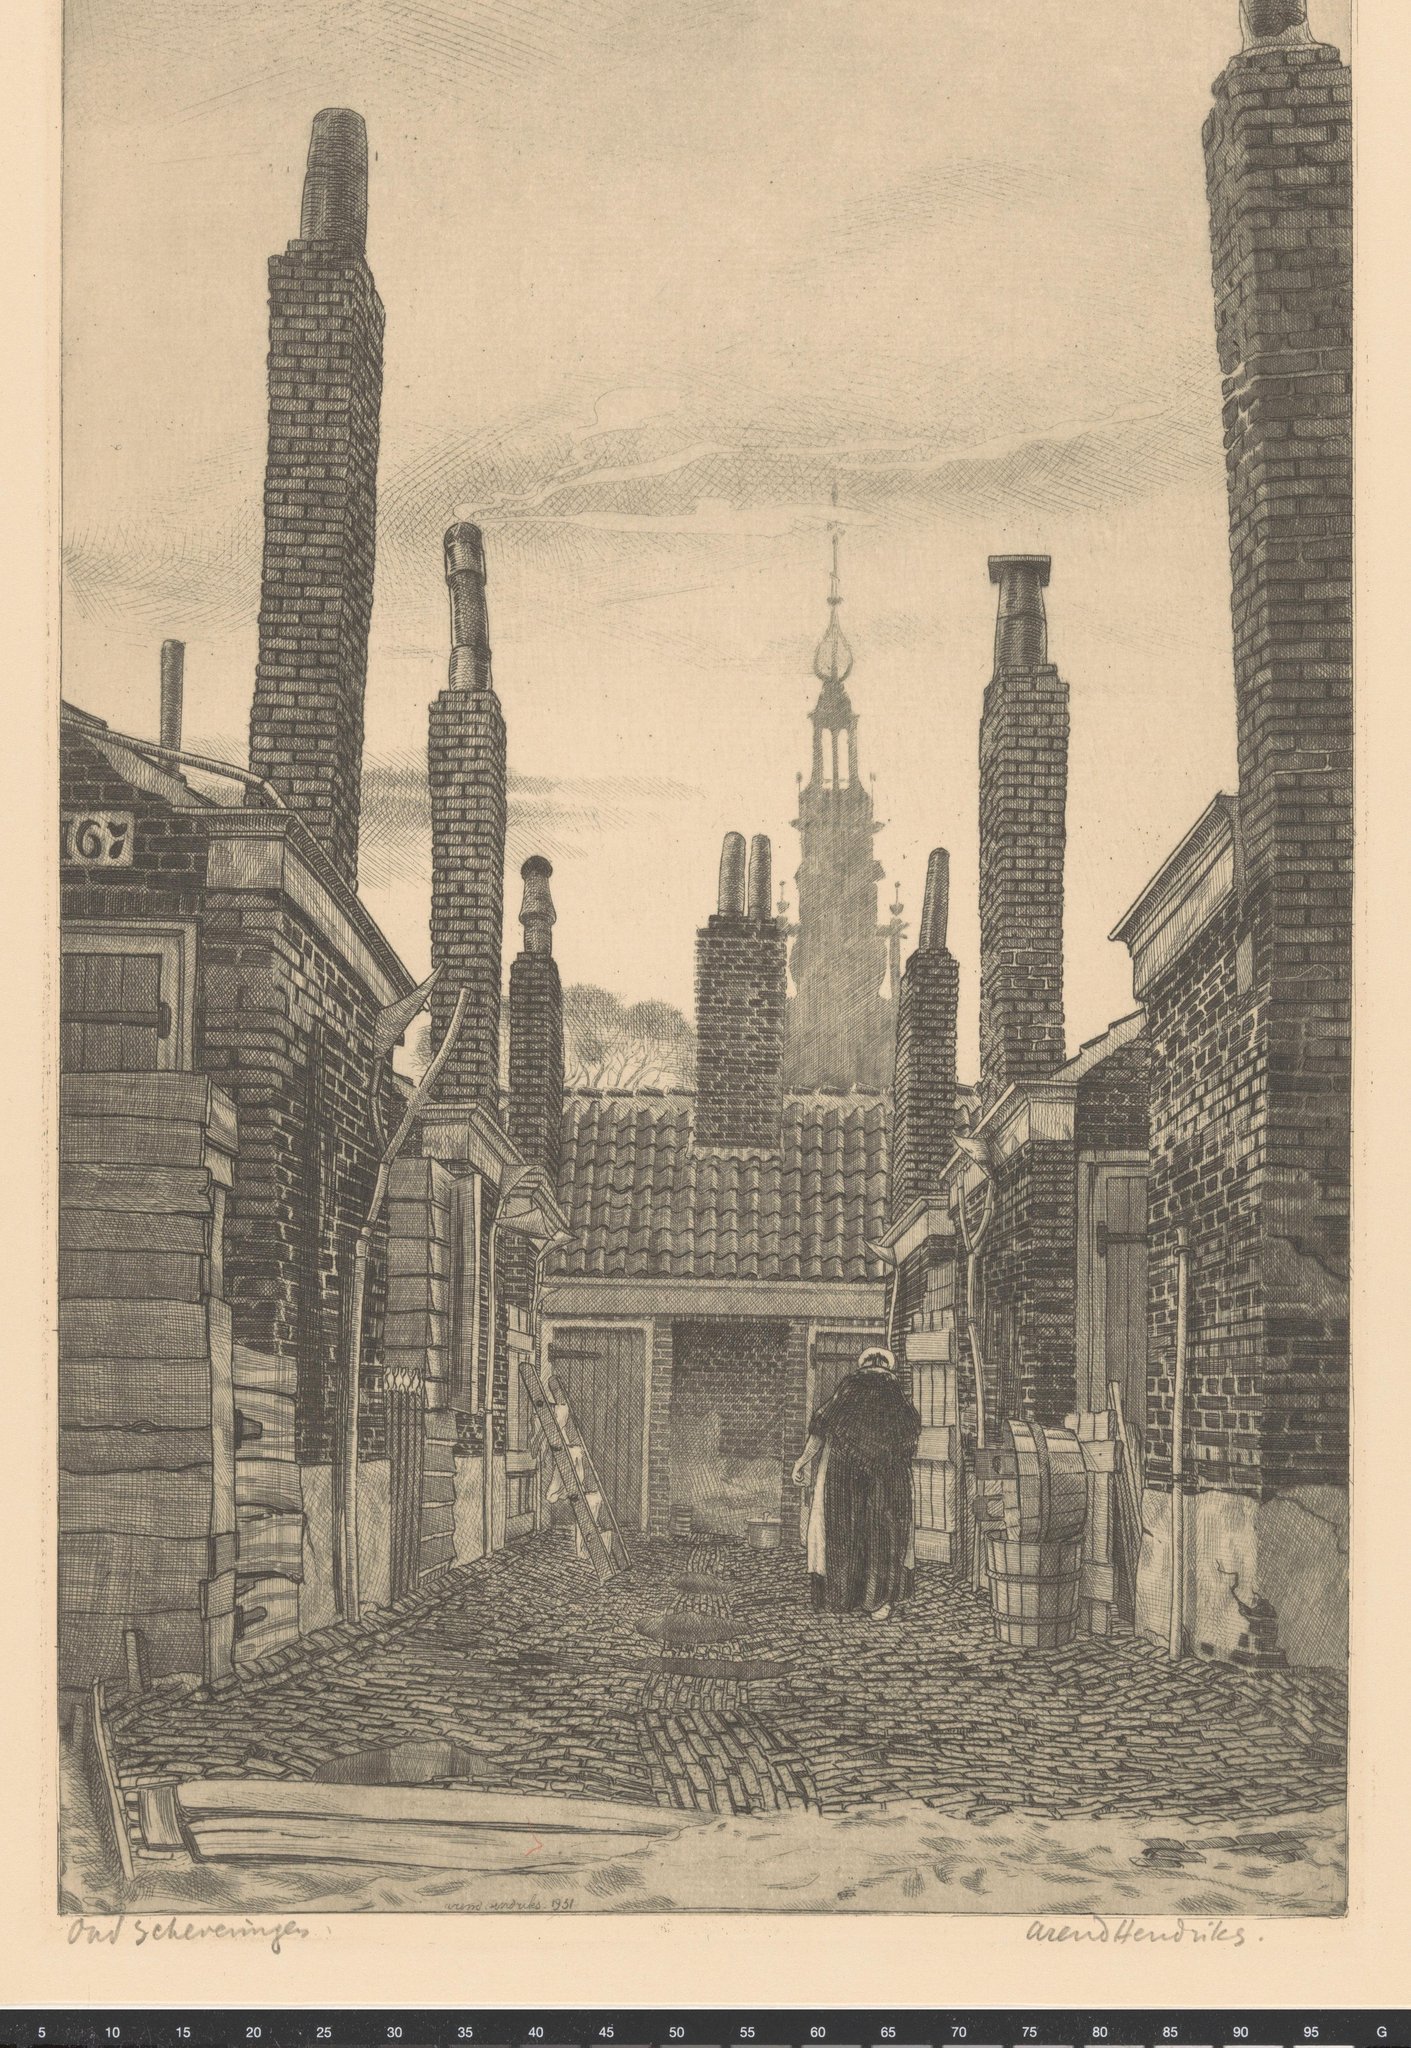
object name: print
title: Oud Scheveningen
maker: arend hendriks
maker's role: print maker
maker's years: 1901-1951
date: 1911-1931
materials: paper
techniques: etching, intaglio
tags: street, parts of church exterior and annexes: tower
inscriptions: collector's mark: Lugt 2228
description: Een vrouw in een straat in Scheveningen. Op de achtergrond het silhouet van een kerktoren.